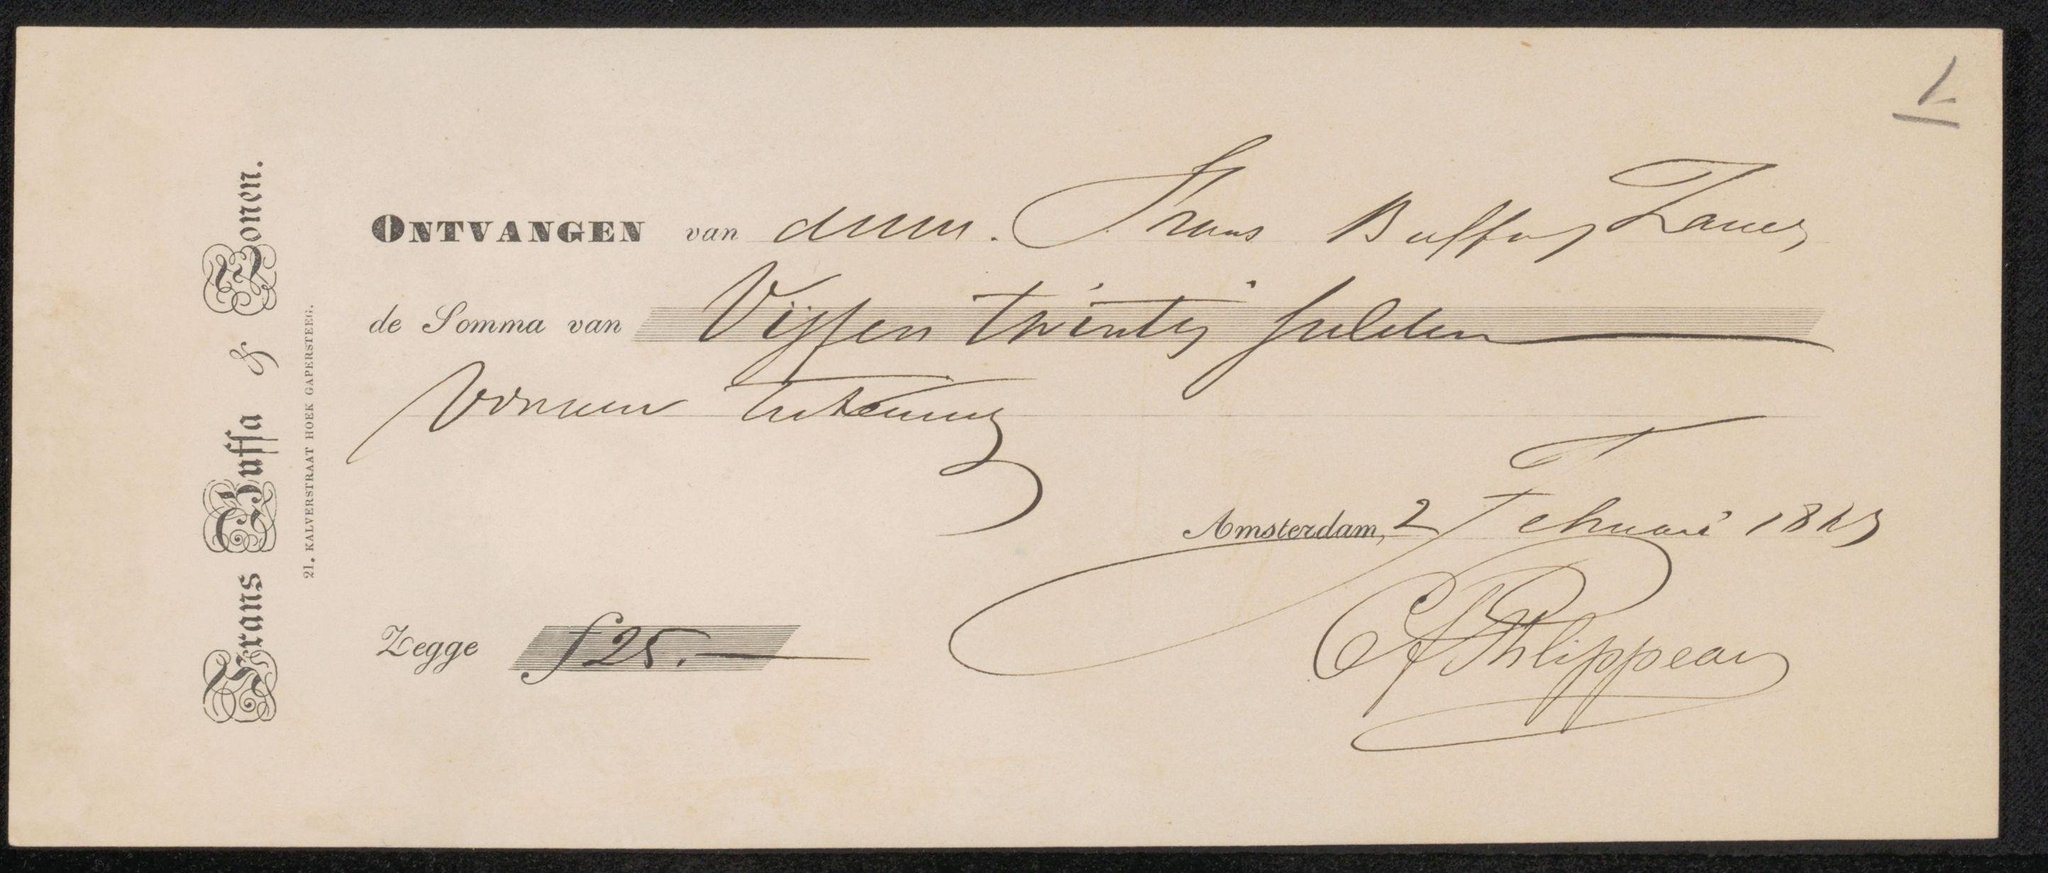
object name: ontvangstbewijs, kwitantie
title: Kwitantie voor Karel Frans Philippeau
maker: karel frans philippeau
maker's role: draughtsman, painter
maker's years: 1825-1897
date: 1863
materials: ink, paper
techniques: pen, printing, writing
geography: amsterdam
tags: drawing, money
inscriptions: collector's mark: Lugt 2233